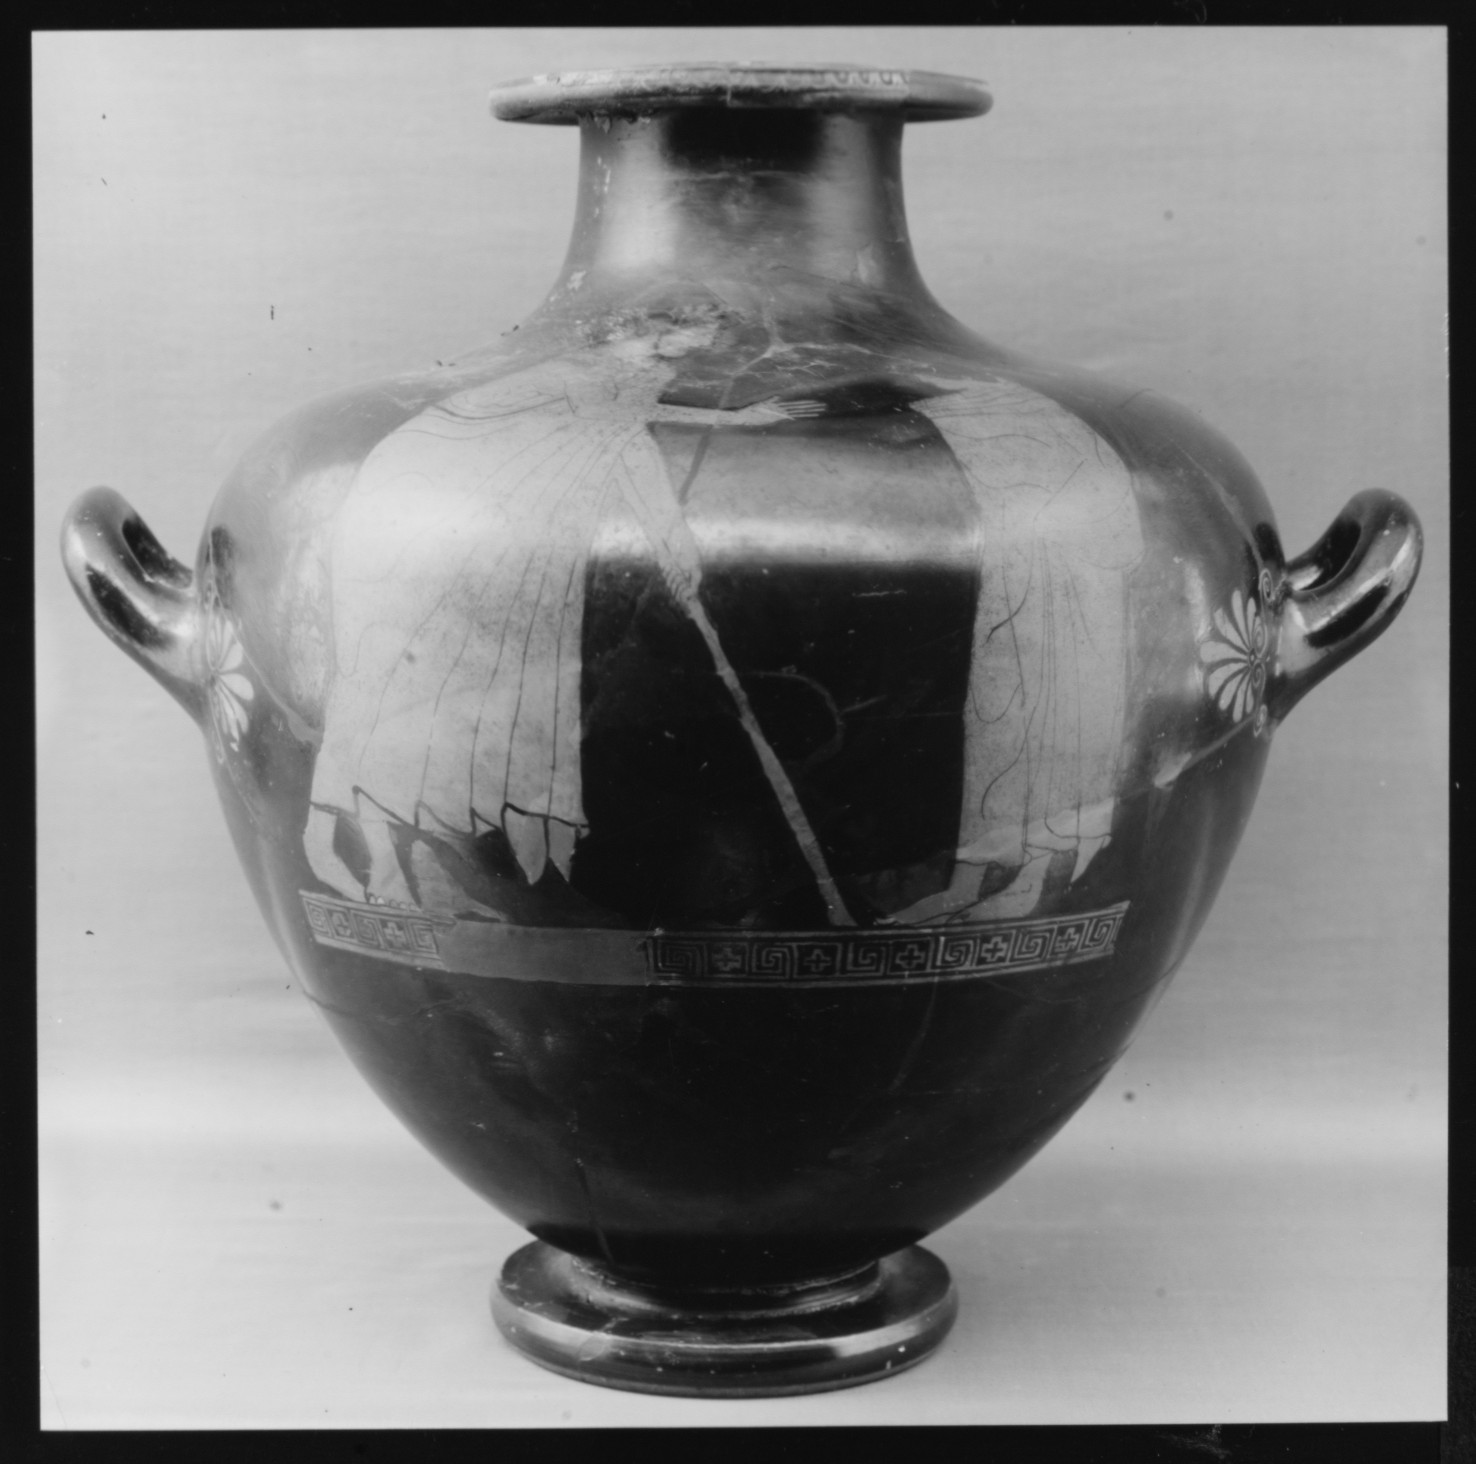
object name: hydria, kalpis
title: Terracotta hydria: kalpis (water jar)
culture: greek, attic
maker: syleus painter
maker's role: artist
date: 480-470 BCE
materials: terracotta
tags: boys,men